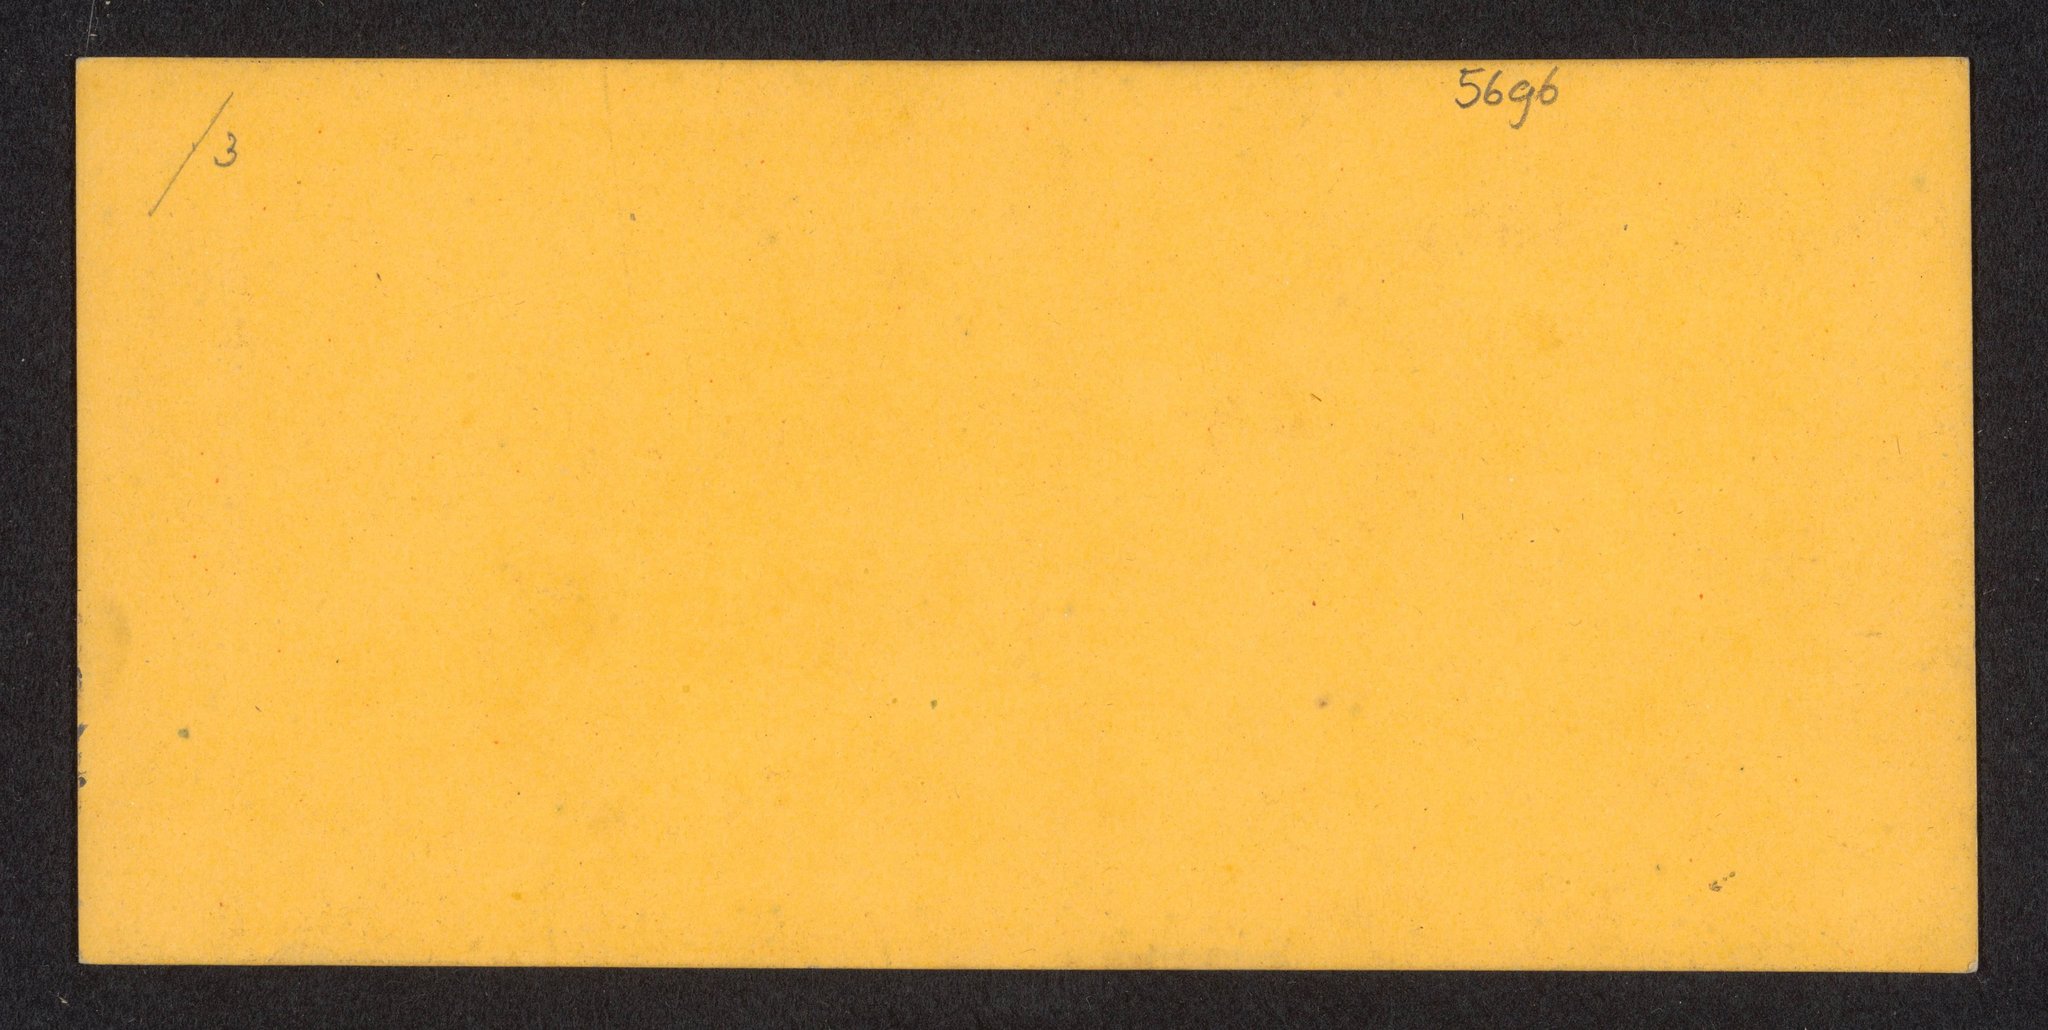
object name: stereograph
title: Colonne de Juillet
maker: Anonymous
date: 1850-1880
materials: cardboard, photographic support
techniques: albumen print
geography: paris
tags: square, place, circus, etc., monument, statue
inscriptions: number: ‘/3’